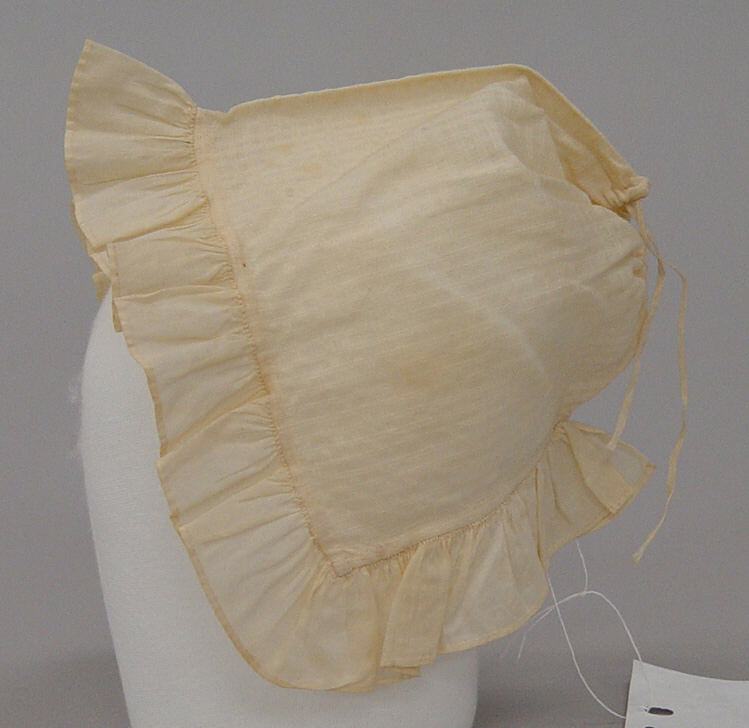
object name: cap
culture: american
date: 1801-1900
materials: cotton